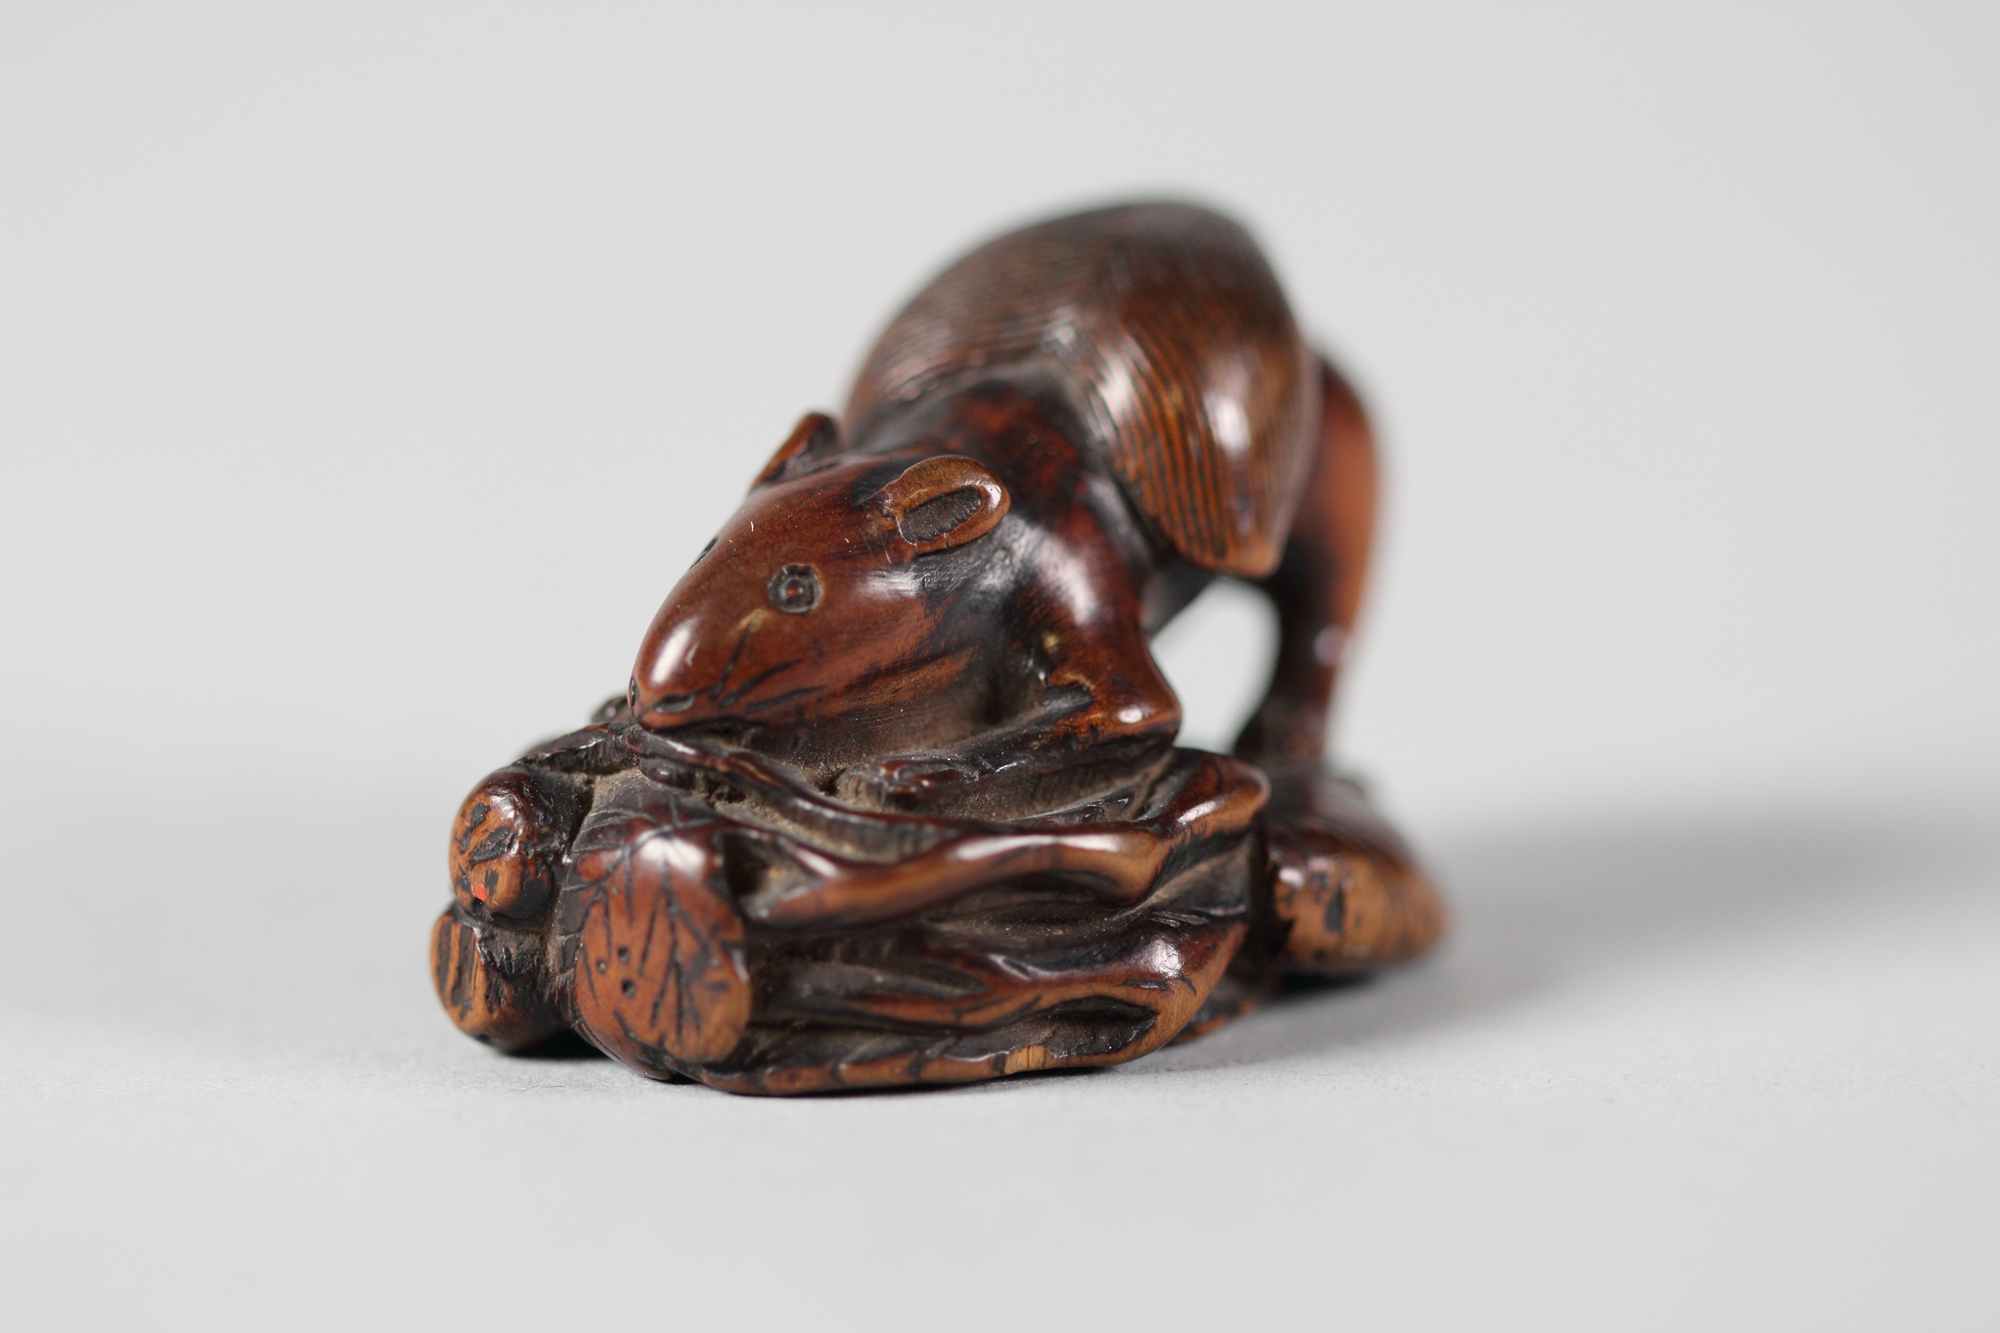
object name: netsuke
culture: japanese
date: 1801-1900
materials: wood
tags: animals